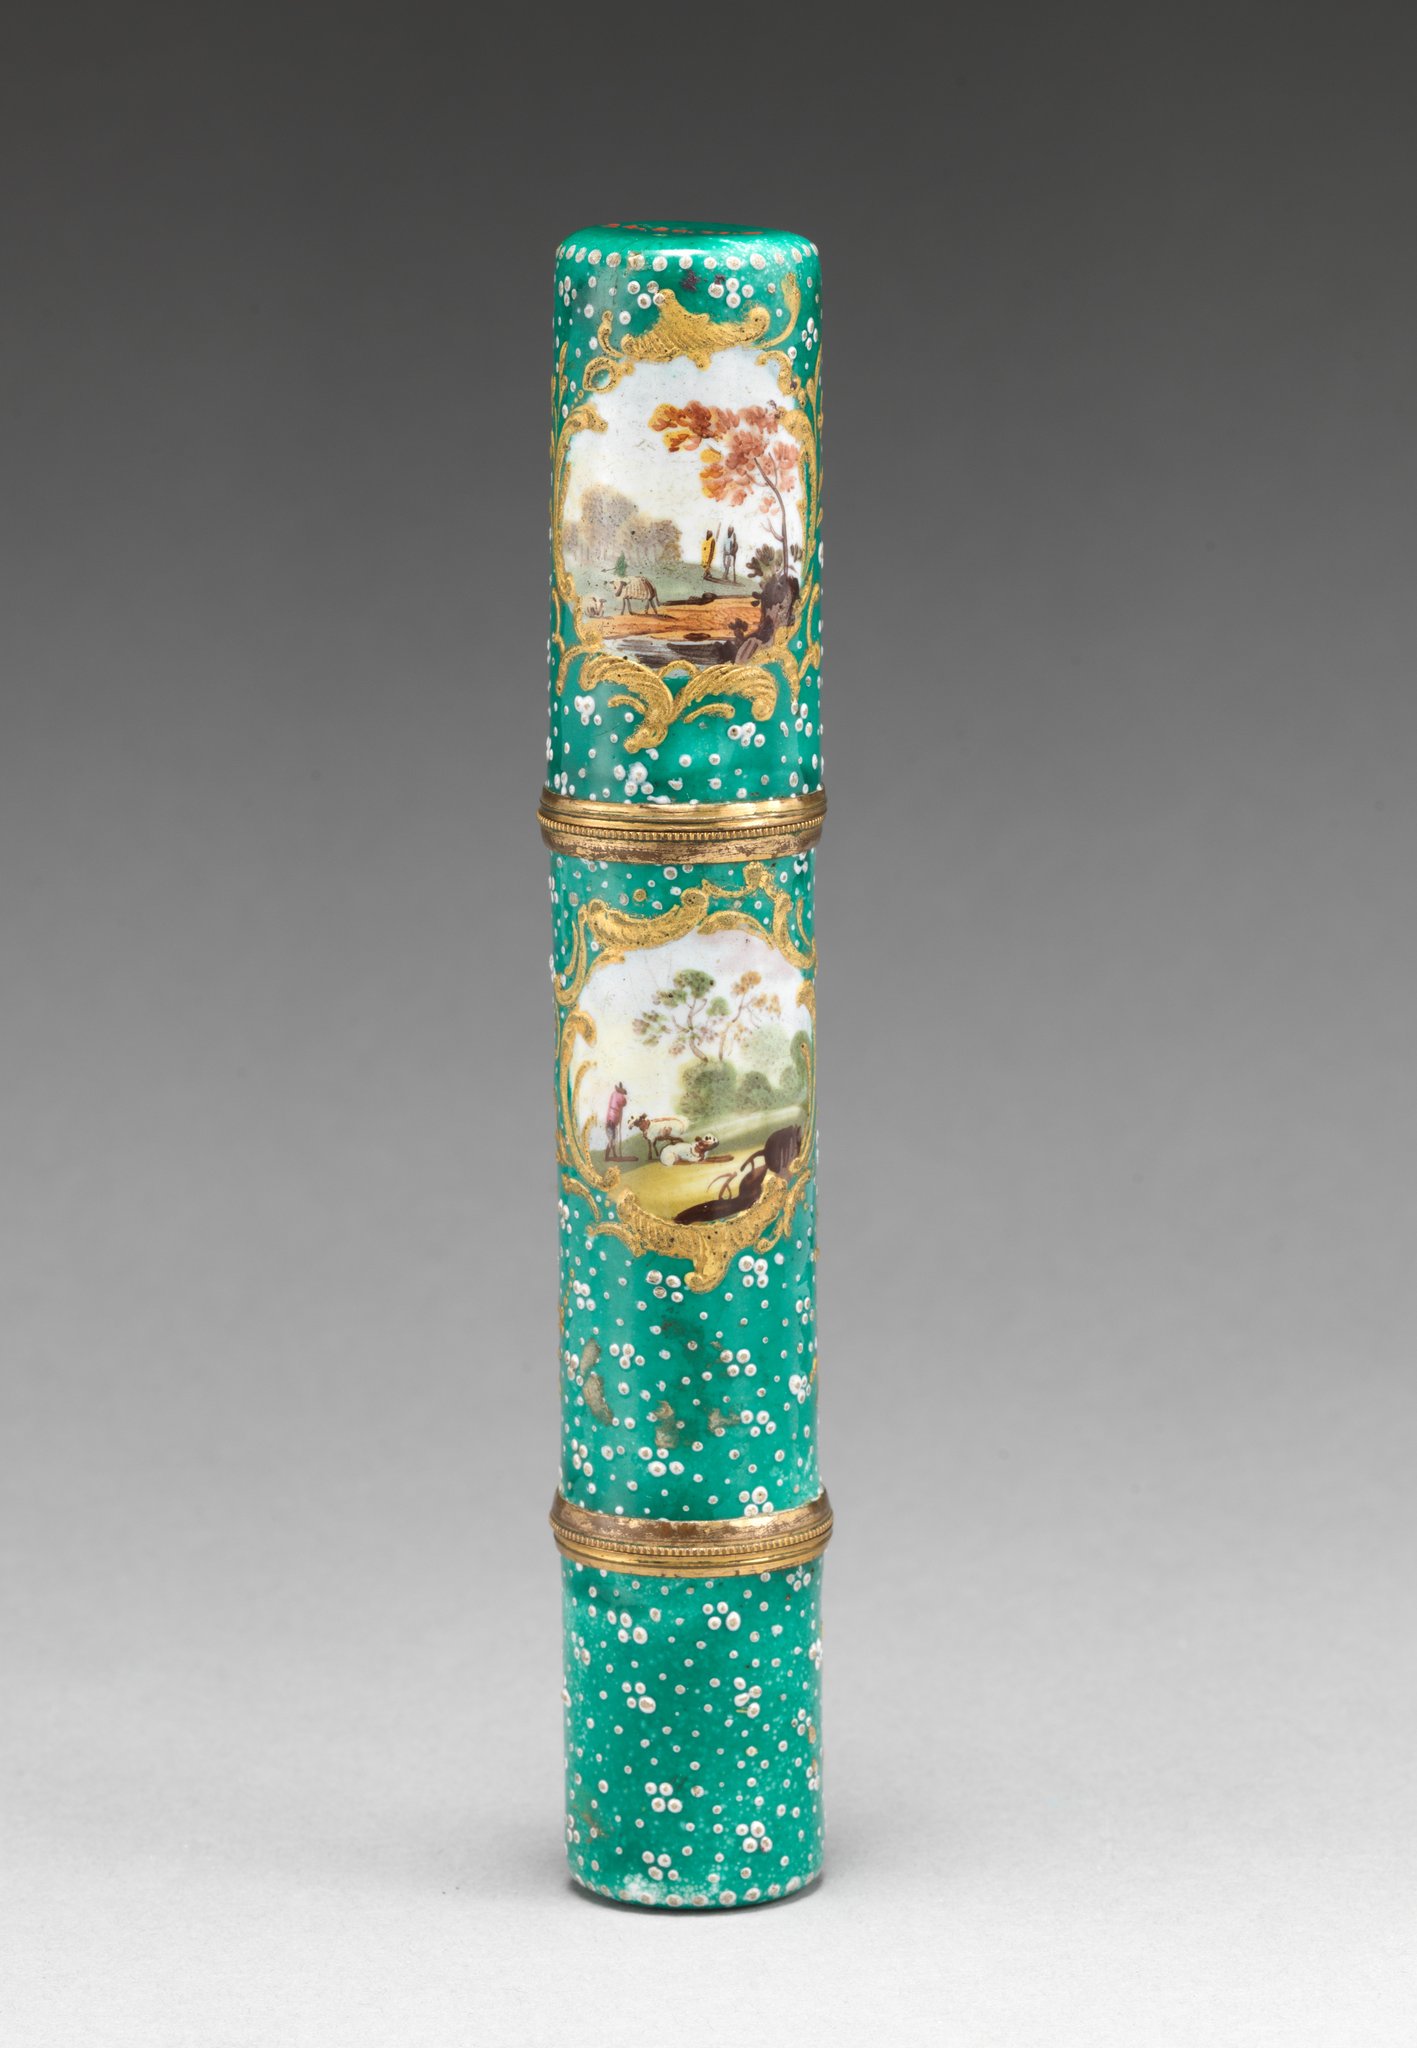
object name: étui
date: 1765-1770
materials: copper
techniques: enamel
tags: human figures,animals,trees